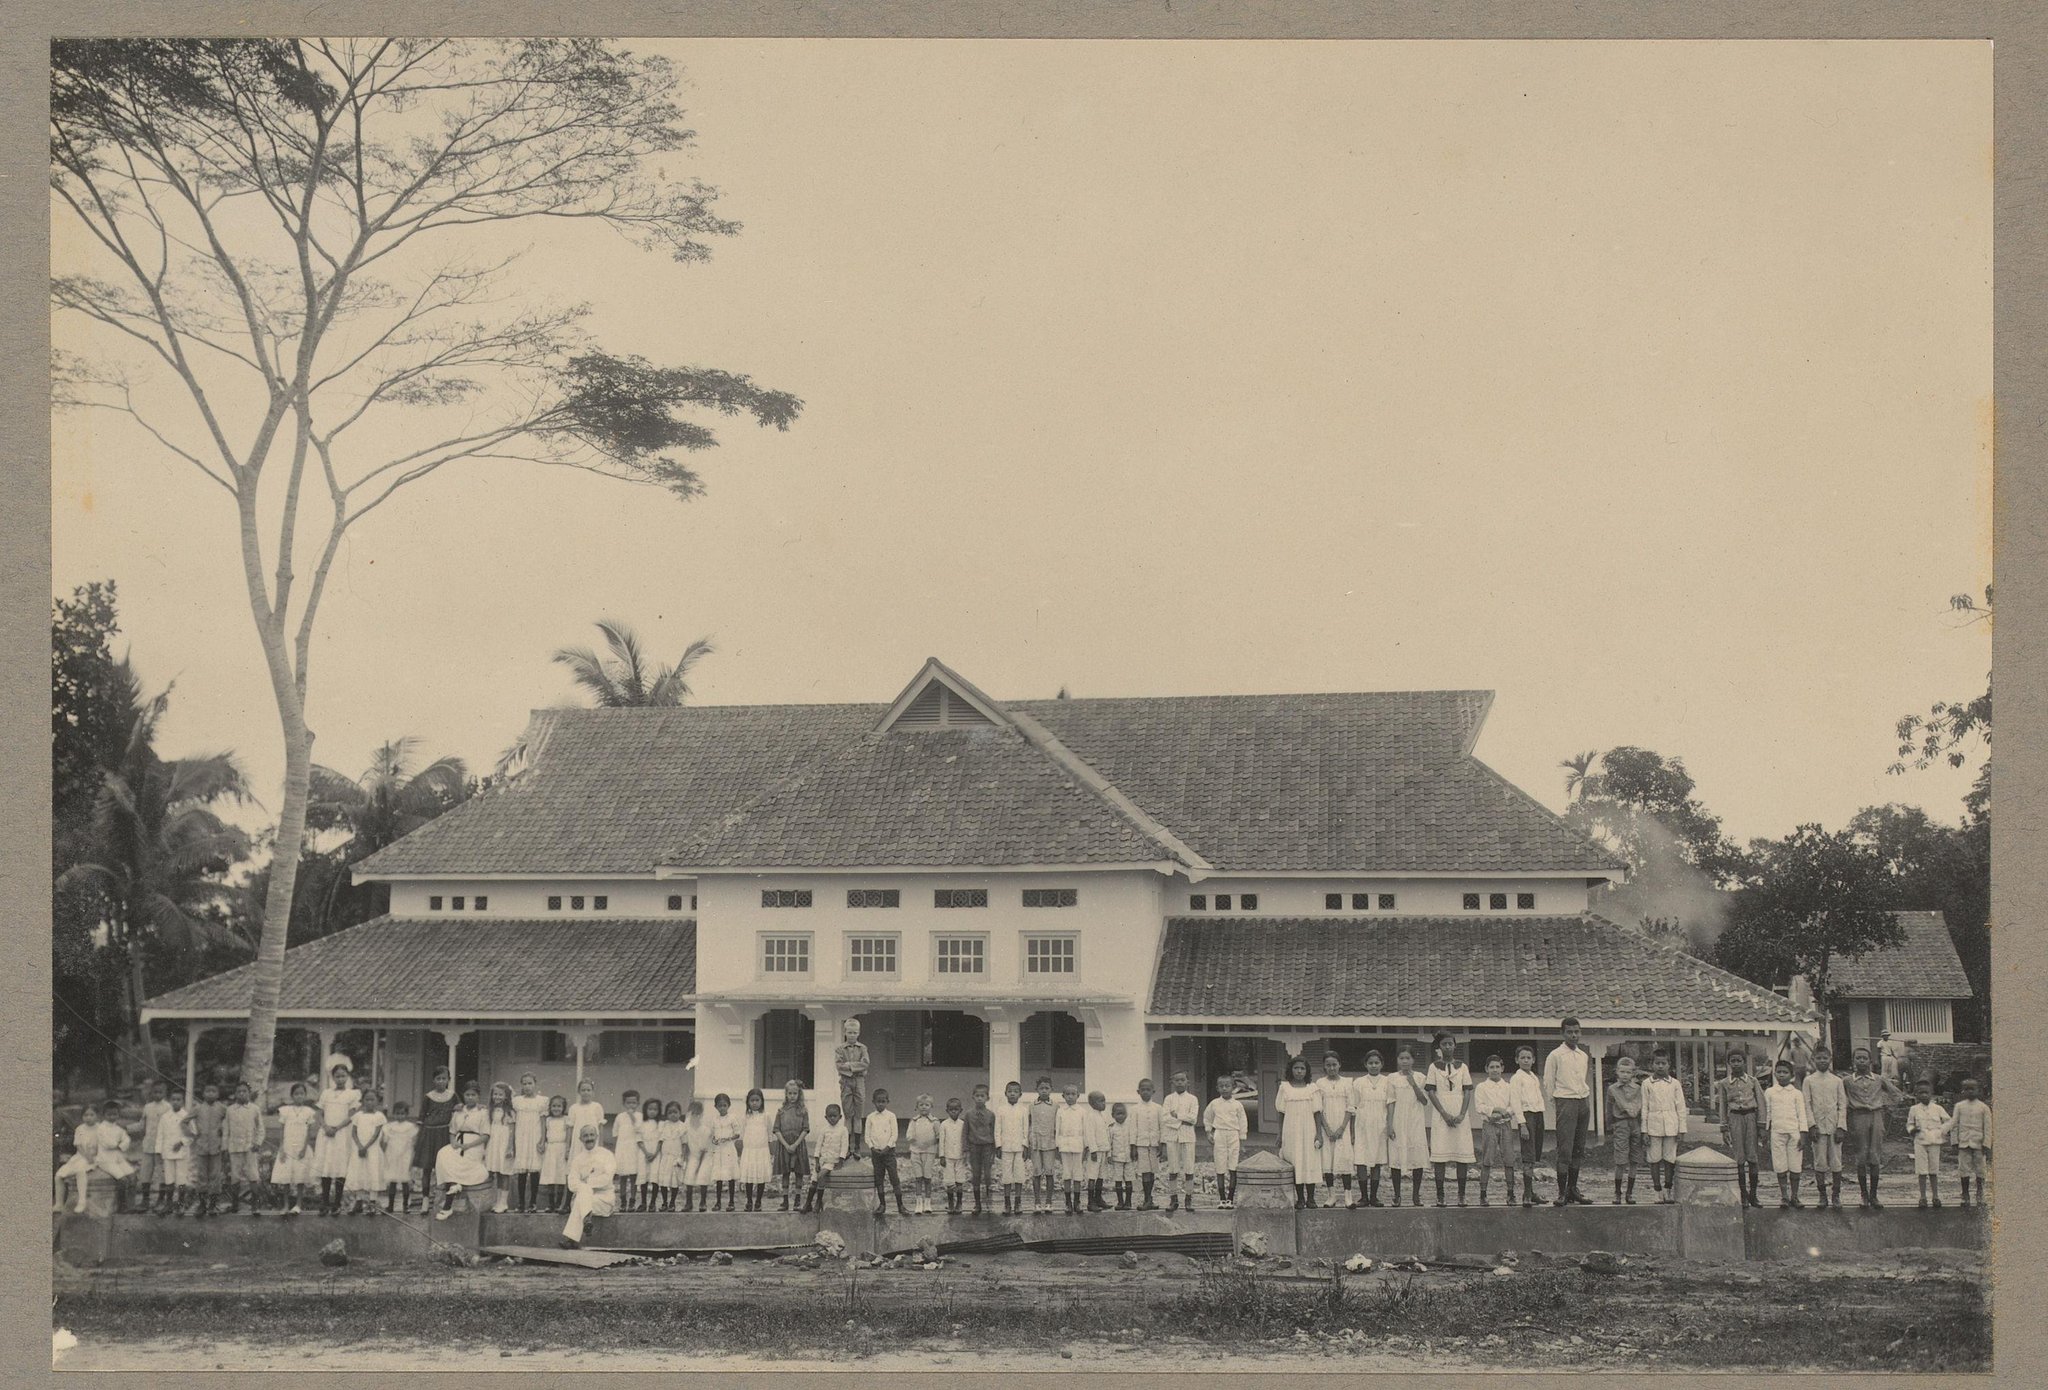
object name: photograph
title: Pangkalpinang. Hollandsche school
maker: Anonymous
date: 1914-1919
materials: photographic support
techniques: gelatin silver print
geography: bangka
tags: robert julius boers, colonial system, mining, elementary school; class, form (+ pupil)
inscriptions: inscription: ‘Pangkalpinang. Hollandsche school’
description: Groepsfoto van de leerlingen voor het gebouw van de Hollandse School van de Banka-tinwinning te Pangkalpinang. Onderdeel van het fotoalbum aangeboden aan Robert Julius Boers bij zijn vertrek naar Nederland in 1919 door het personeel van de Banka-tinwinning.